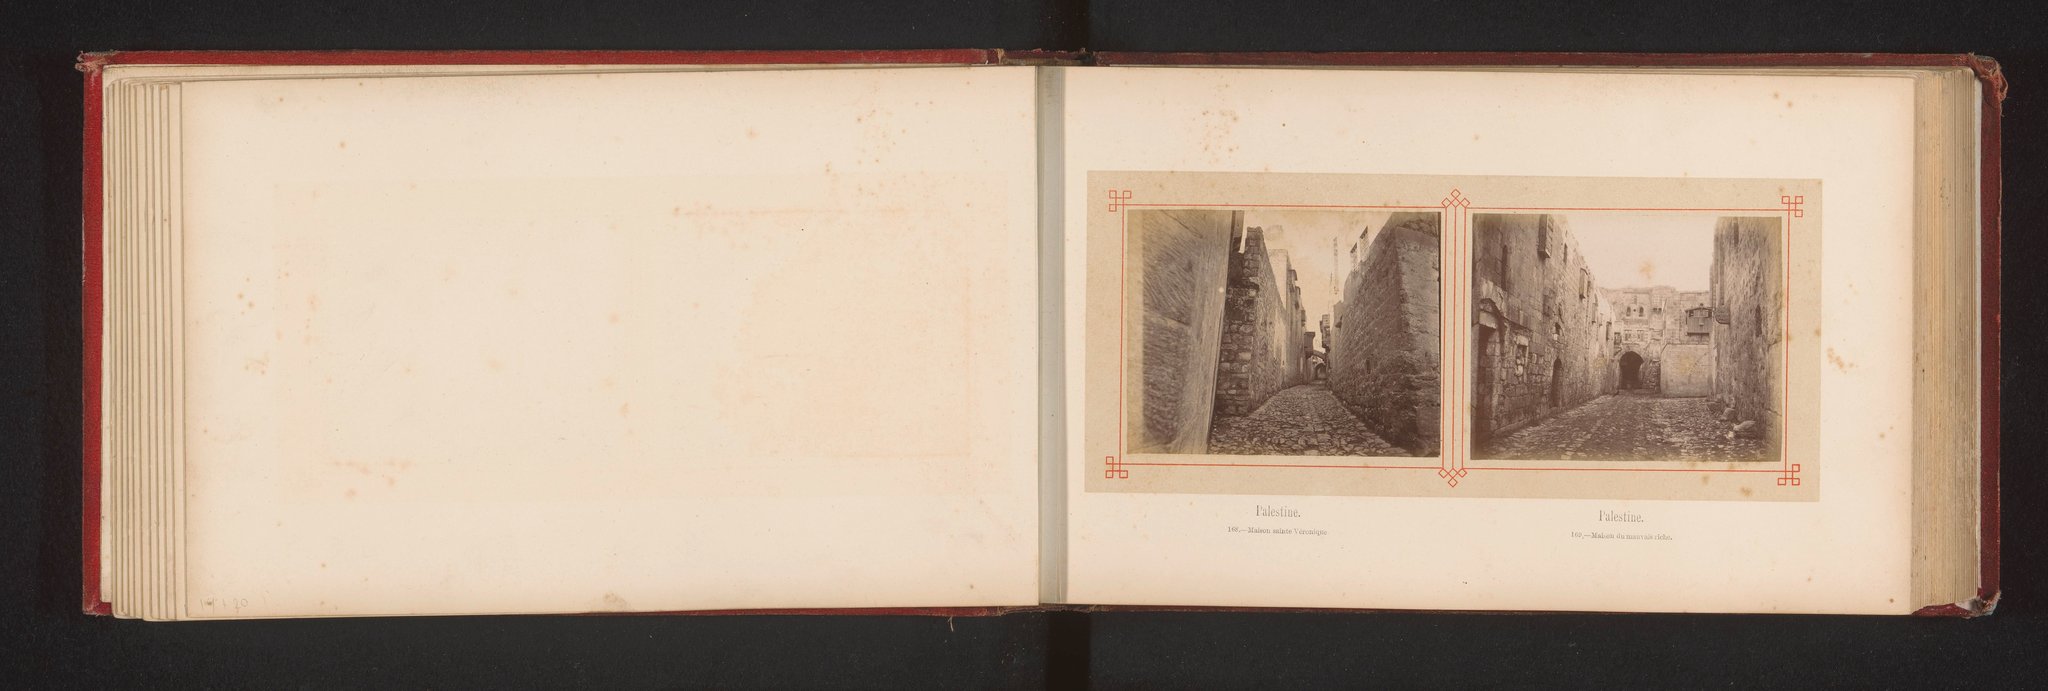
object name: photograph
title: Palestine - 169. Maison du mauvais riche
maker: félix bonfils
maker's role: fotograaf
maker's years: 1831-1885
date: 1873-1878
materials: photographic support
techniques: albumen print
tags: lane, alley